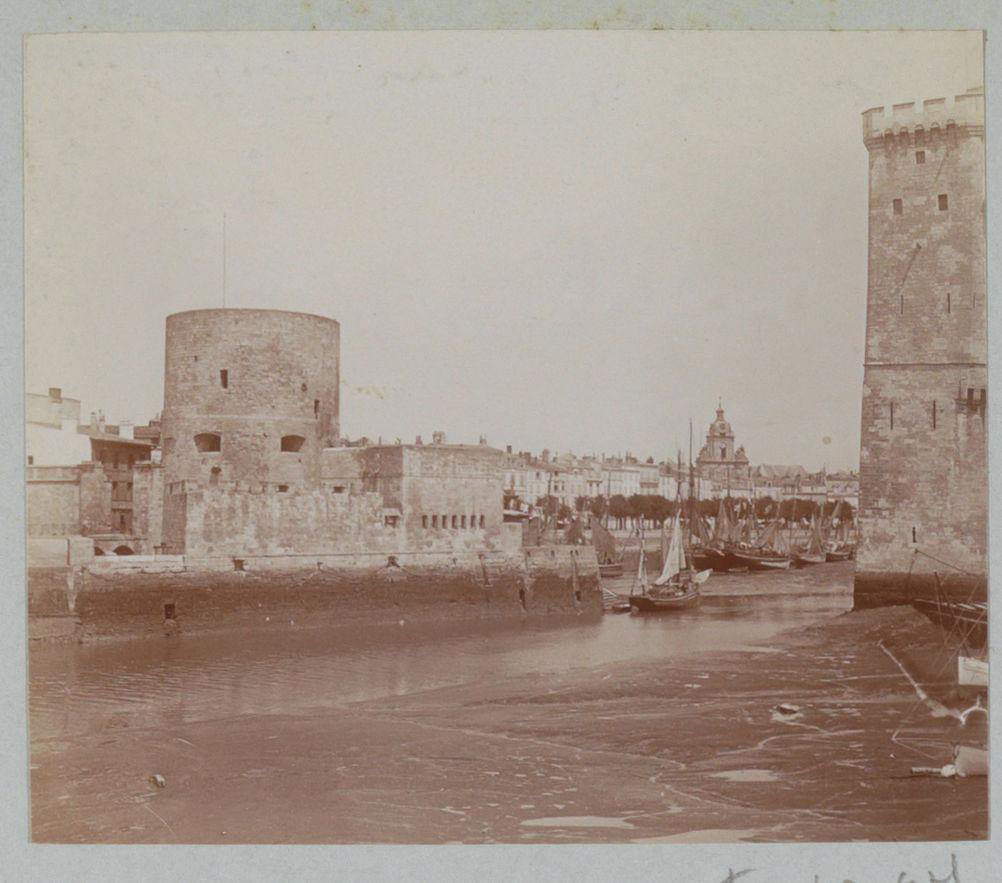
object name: photograph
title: Haveningang van La Rochelle met links de Tour de la Chaîne en rechts de Tour Saint-Nicolas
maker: Anonymous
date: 1905-1910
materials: paper, photographic support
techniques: gelatin silver print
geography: la rochelle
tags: towers ~ fortified city, harbour (+ view ~ vehicle, ship, etc.)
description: Onderdeel van Fotoalbum van een Franse amateurfotograaf met bezienswaardigheden in Frankrijk, Zwitserland en Italië.